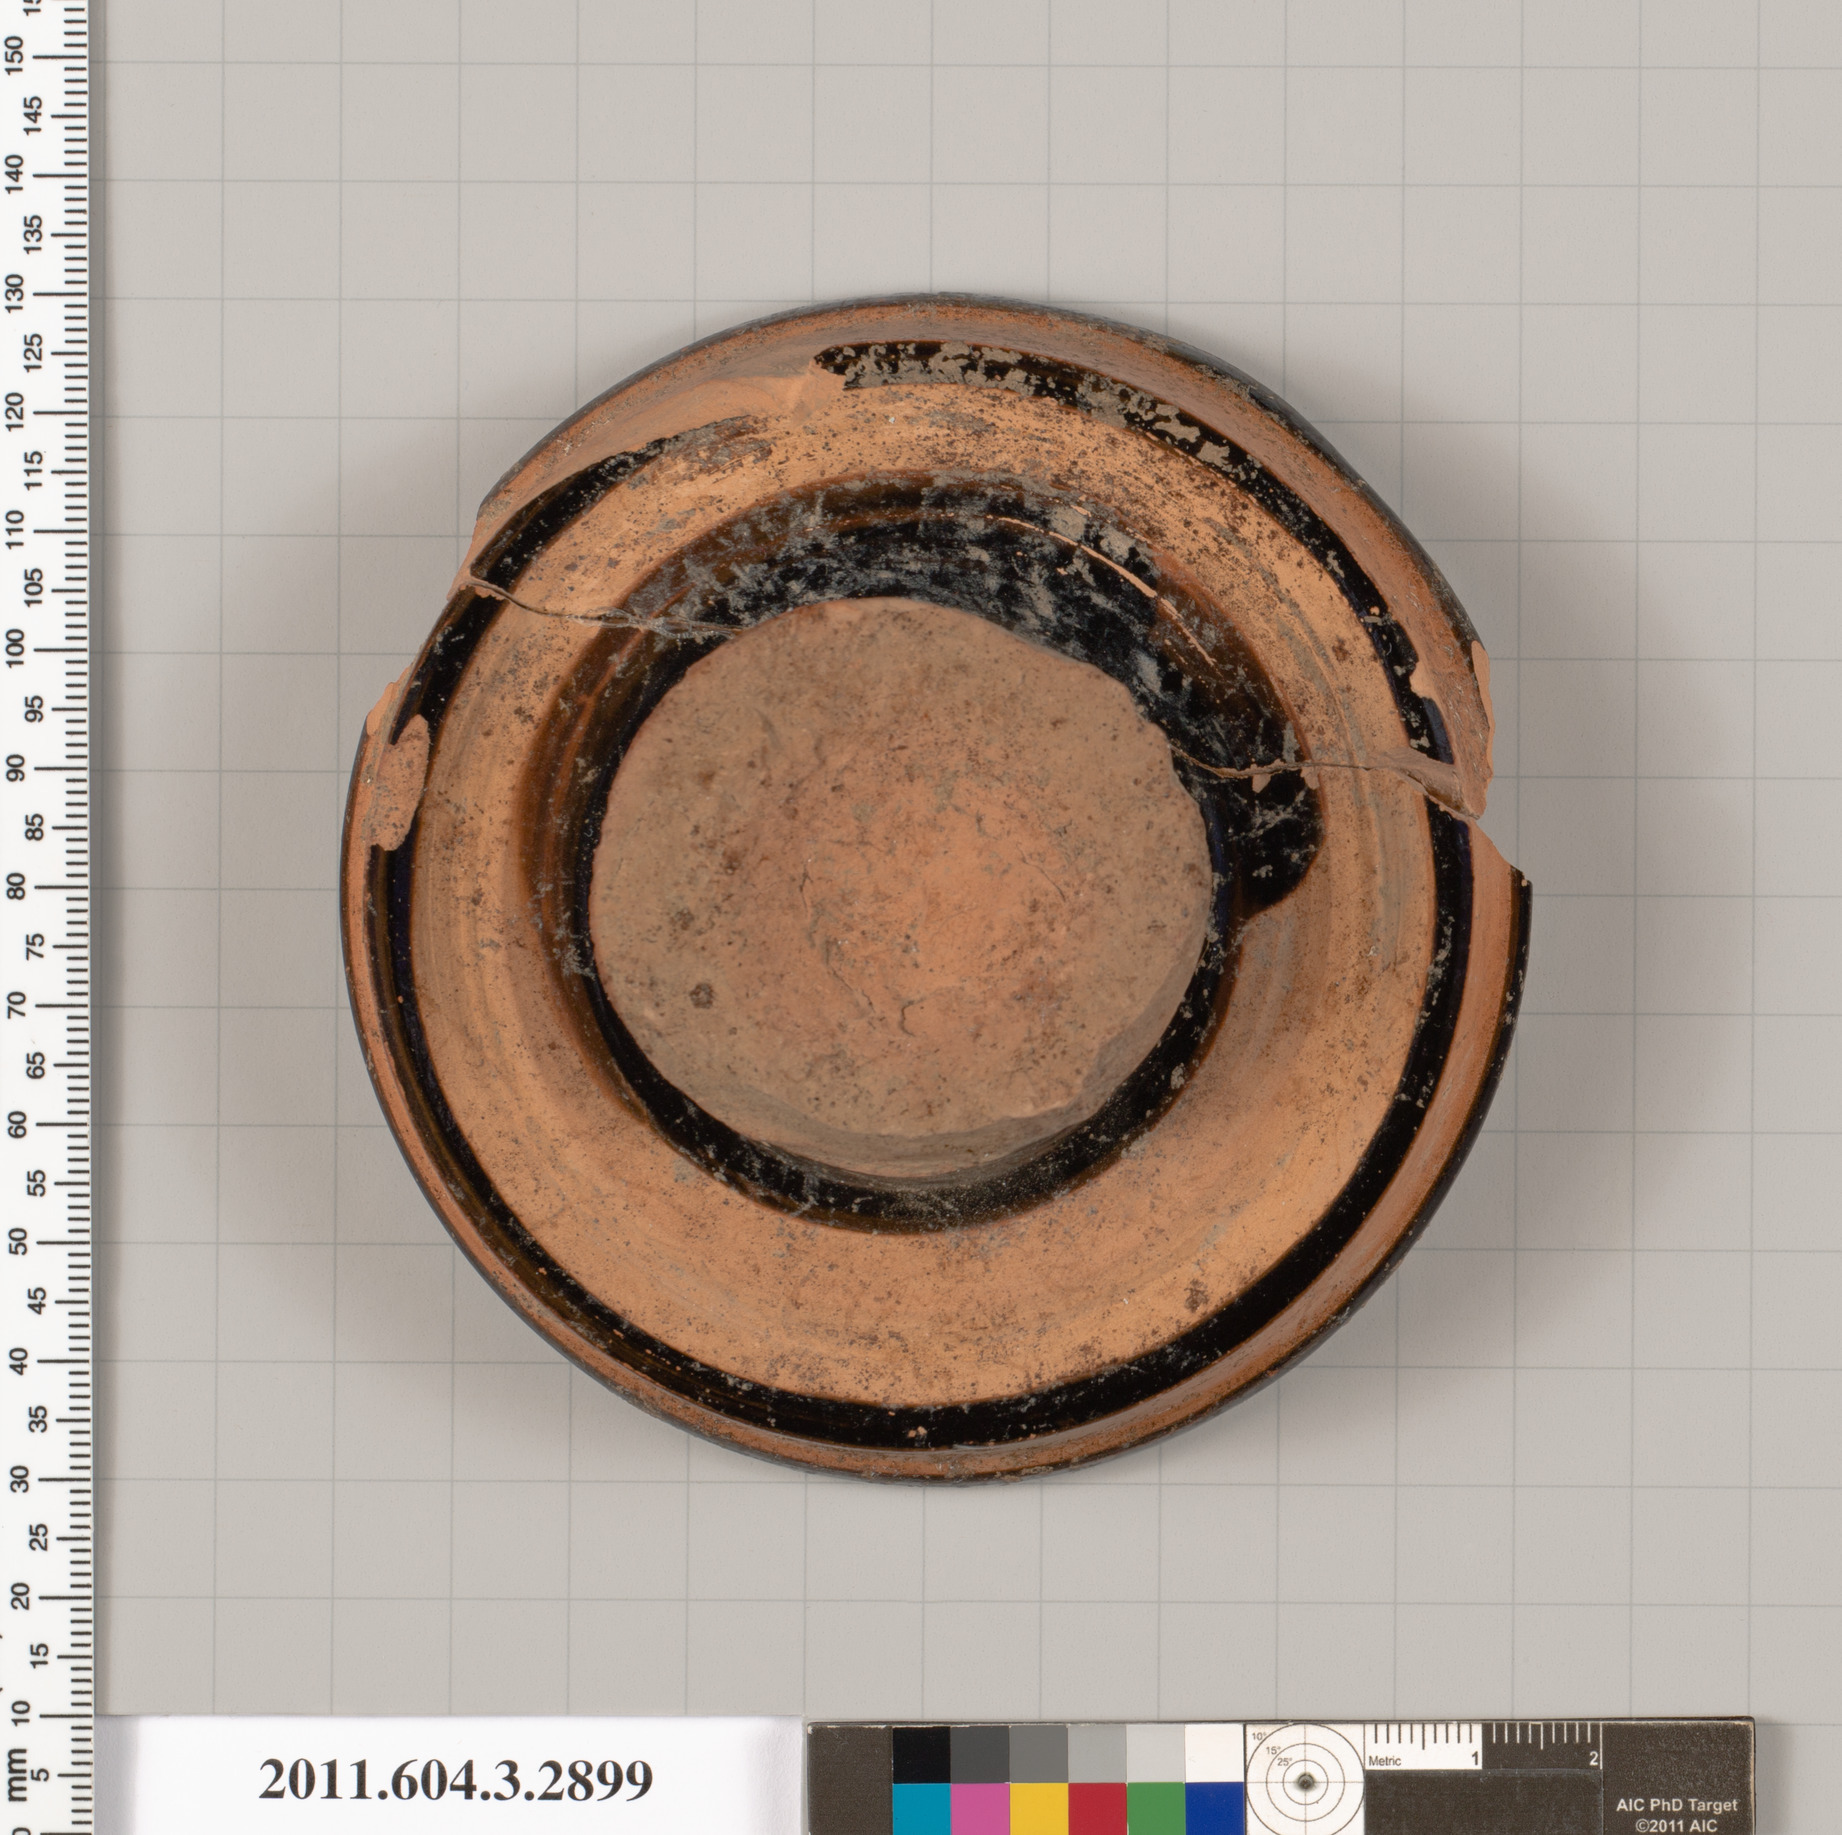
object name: lekythos fragment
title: Terracotta fragment of a lekythos (oil flask)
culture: greek, attic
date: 490-470 BCE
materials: terracotta